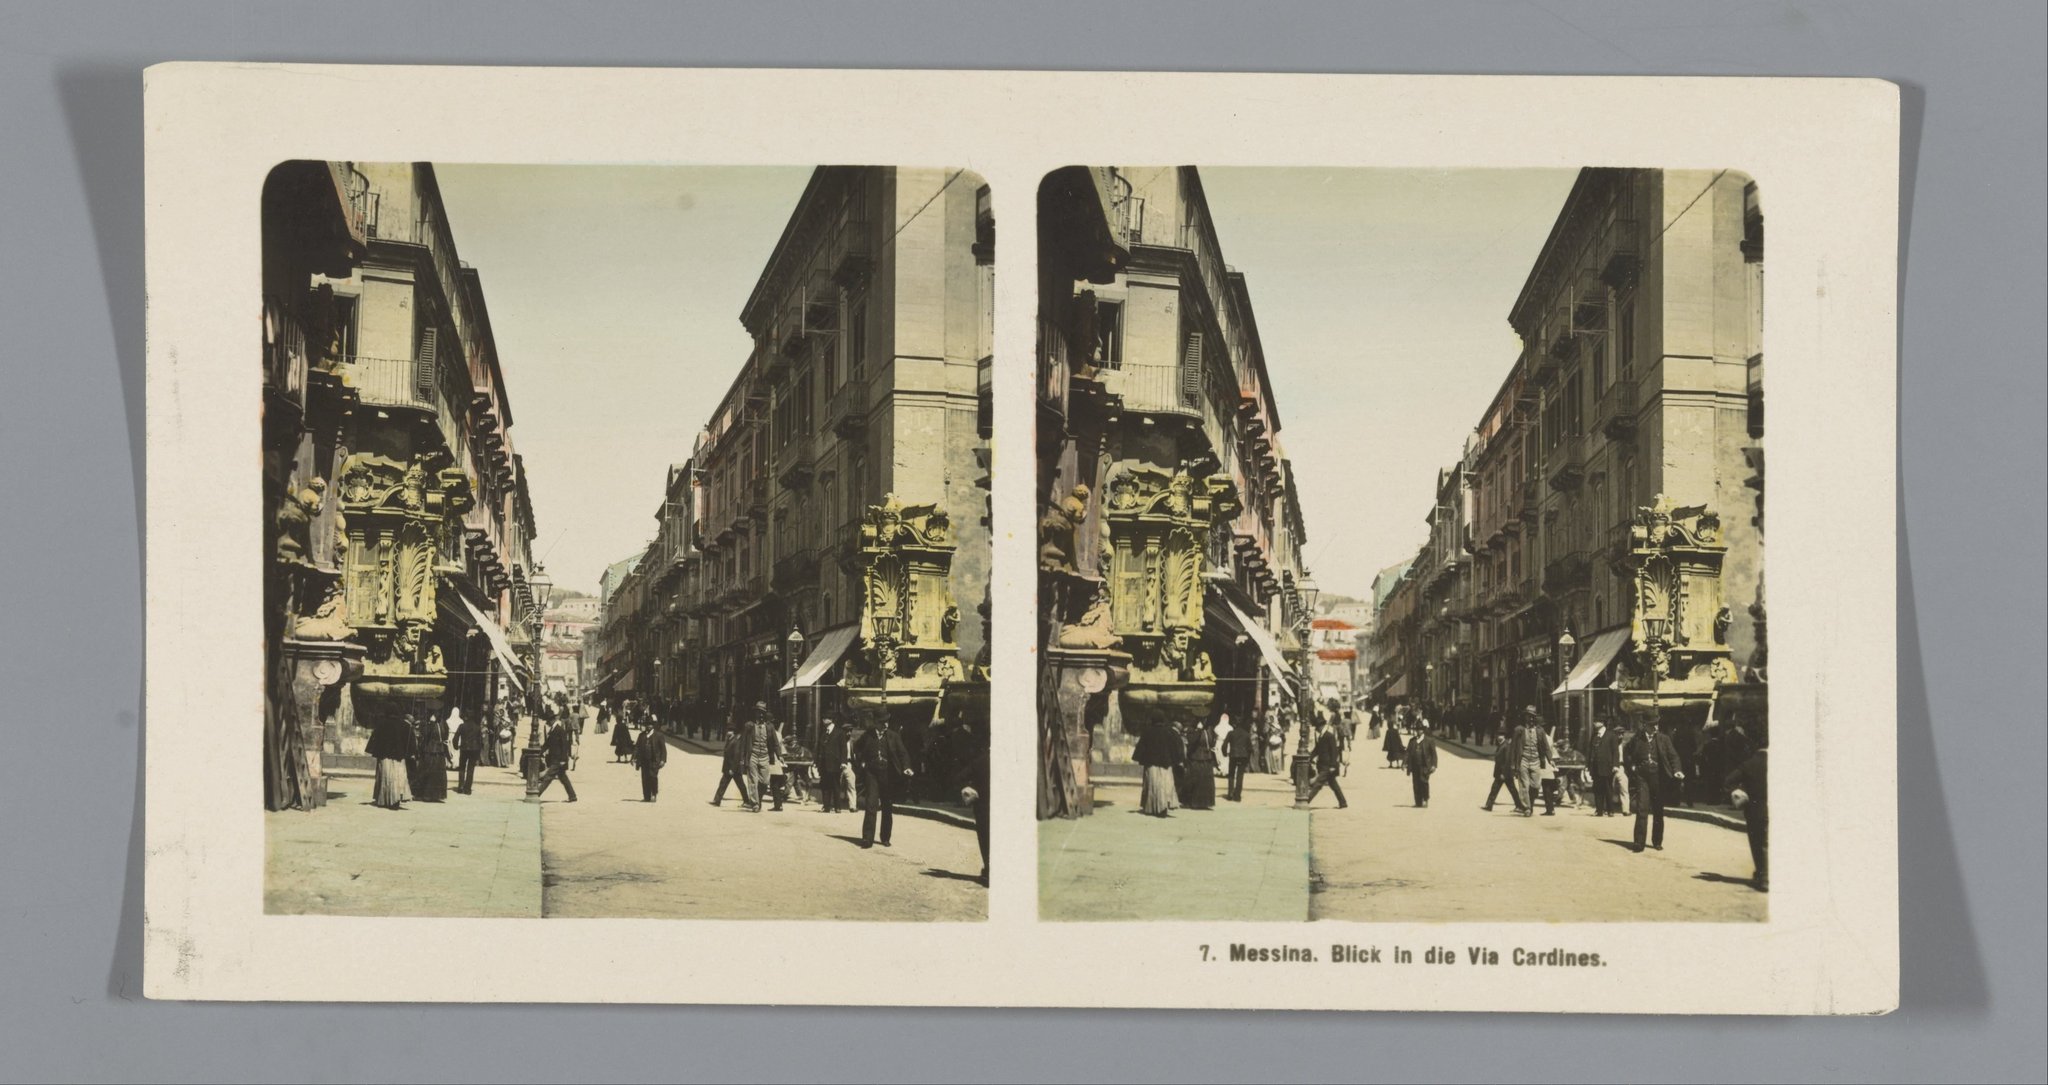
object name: stereograph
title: Gezicht op de Via Cardines te Messina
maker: Anonymous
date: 1900-1940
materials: cardboard, photographic support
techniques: gelatin silver print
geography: messina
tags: street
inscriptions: annotation: ‘BW’, number: ‘7.’